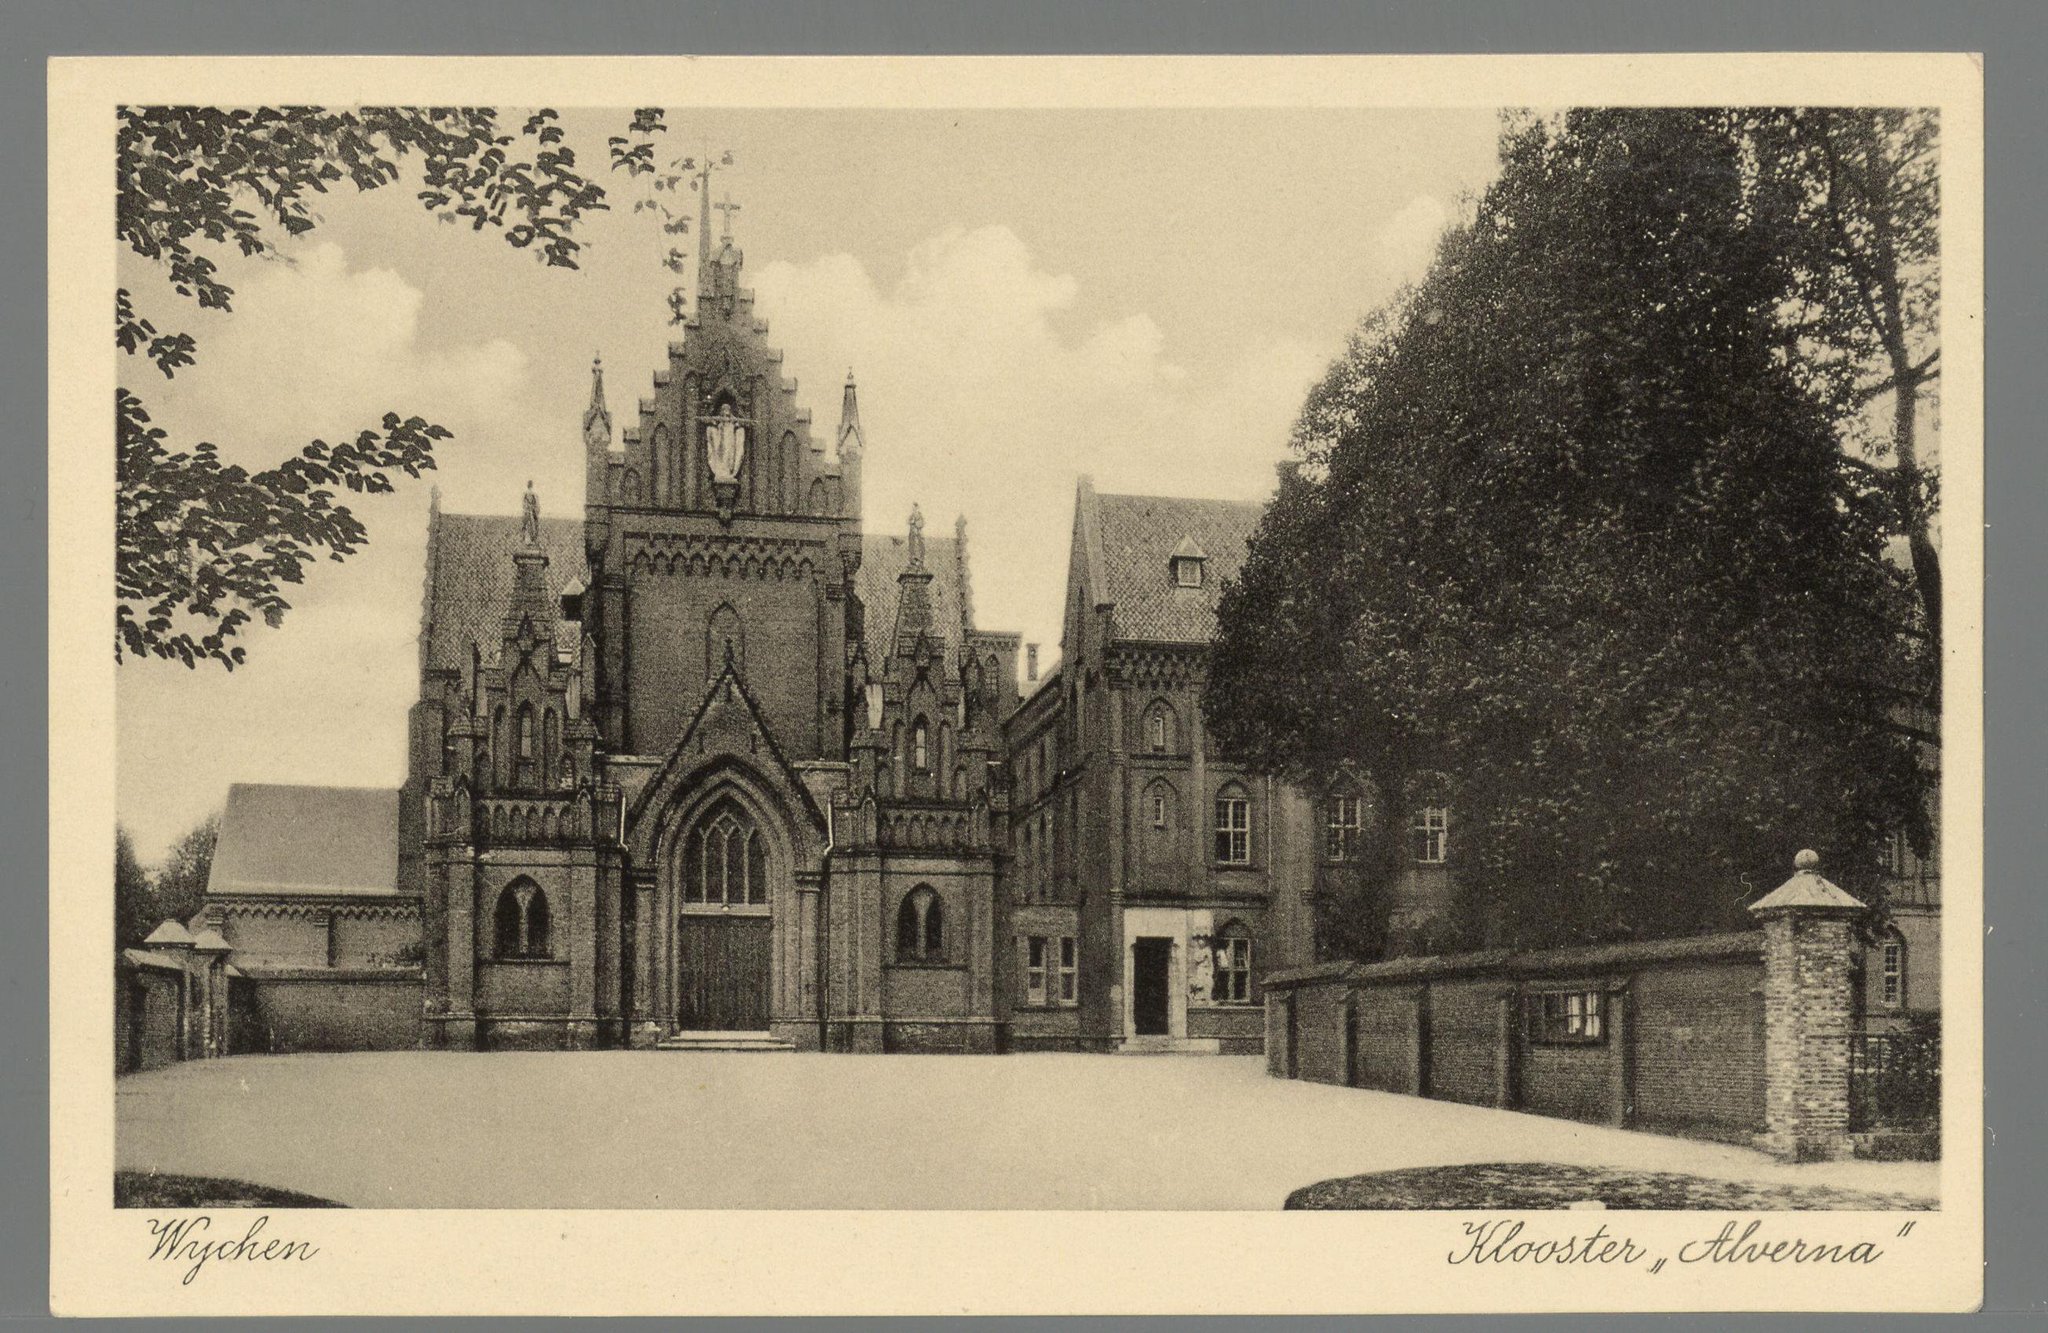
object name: ansichtkaart, prentbriefkaart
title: Wychen. Klooster "Alverna"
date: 1913-1950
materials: cardboard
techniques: photograph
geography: alverna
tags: abbey, monastery, convent ~ roman catholic church